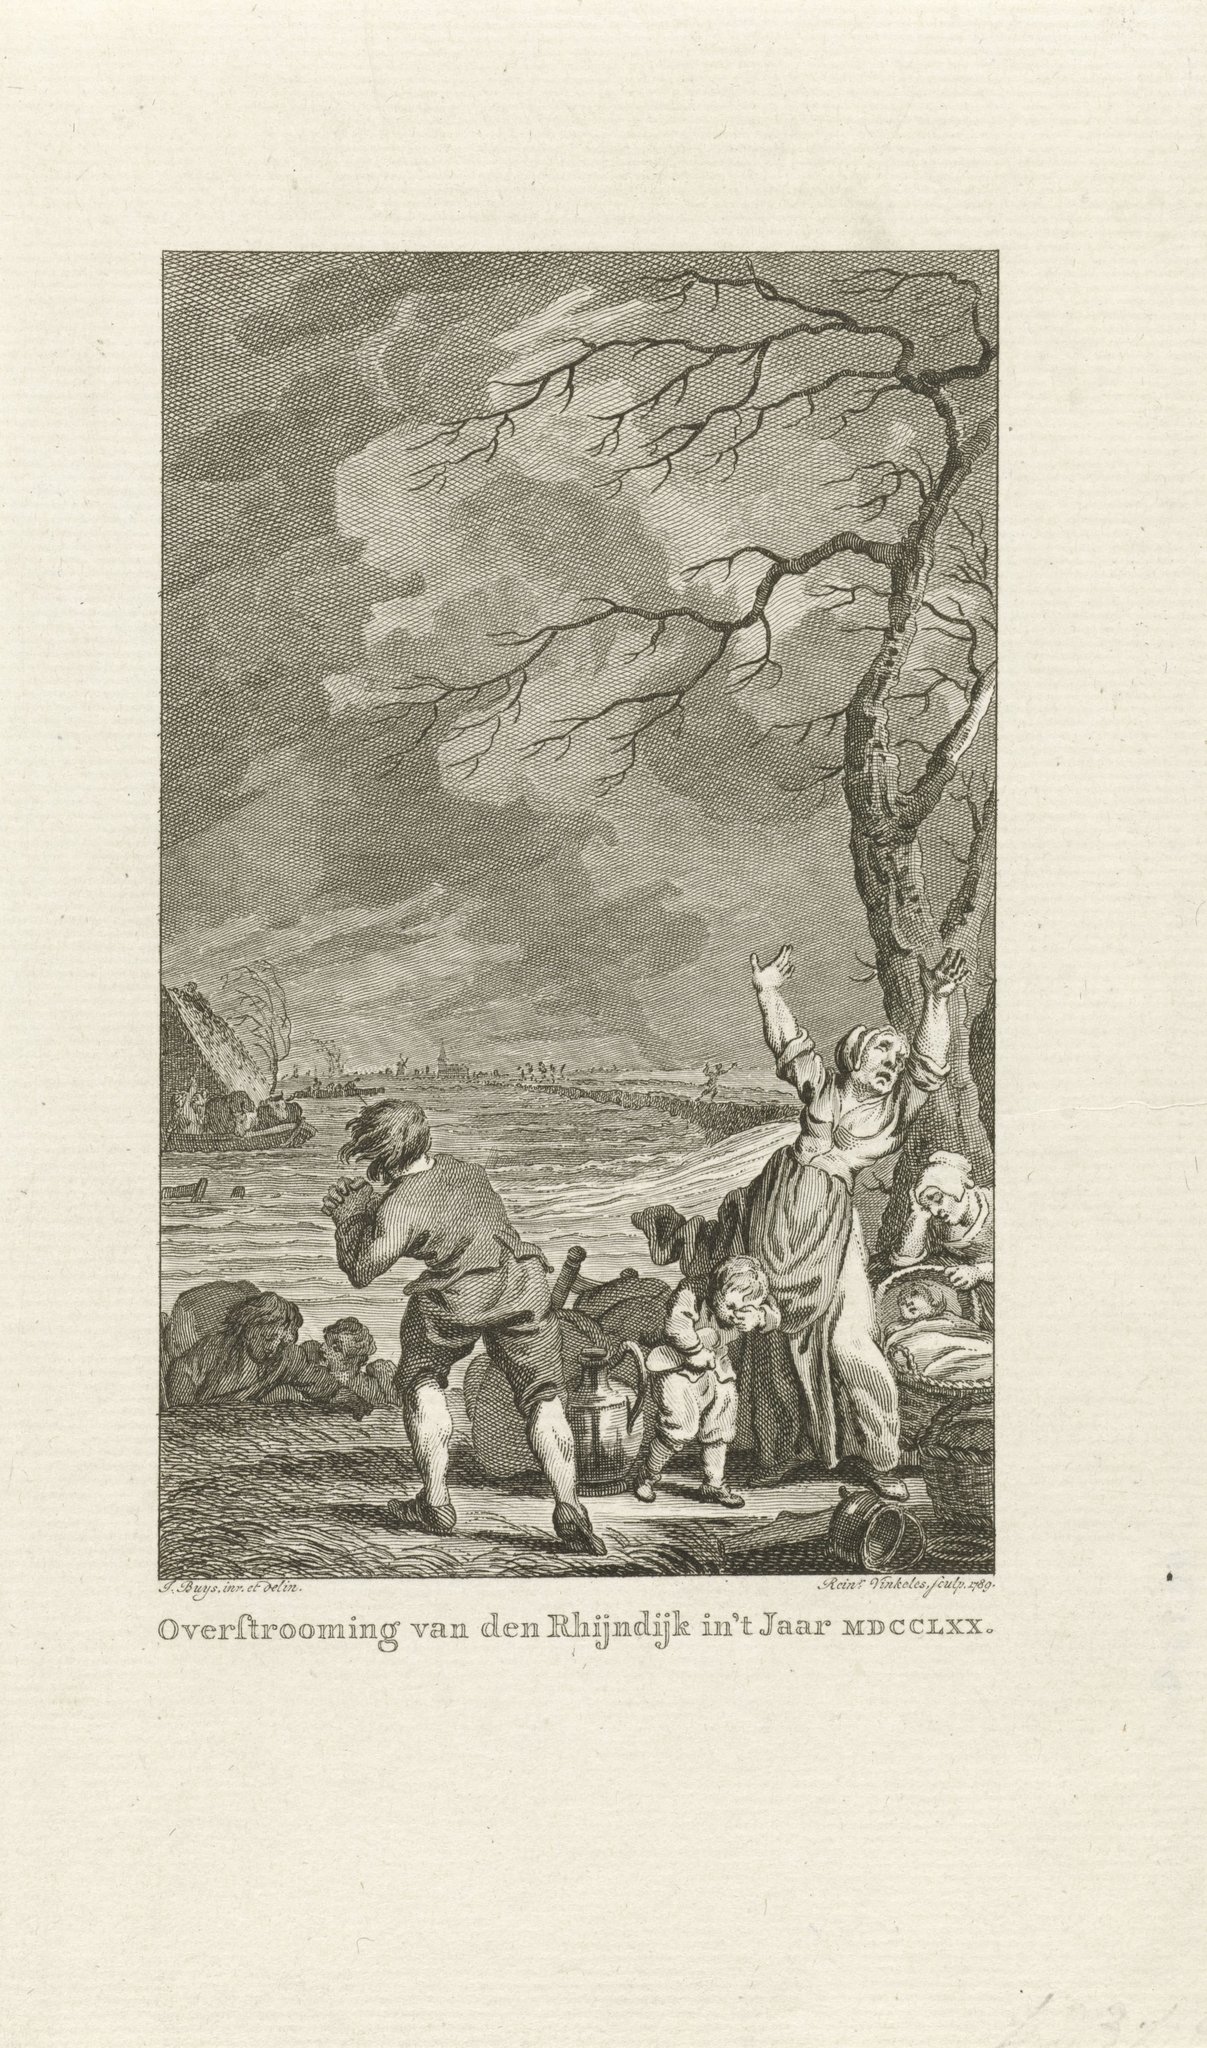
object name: print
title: Overstroming van de Rijndijk in Gelderland, 1770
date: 1789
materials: paper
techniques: etching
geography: northern netherlands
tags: dike-break, gelderland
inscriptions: collector's mark: Lugt 2228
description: Gebruikt als illustratie in: P.A. Loosjes, Vaderlandsche historie, vervattende de geschiedenissen, der Vereenigde Nederlanden (...). Vier-en-twintigste deel. Beginnende met den jaare 1766 en eindigende met den jaare 1774, bevattende het tydperk der meerderjaarigheid des erfstadhouders Willem den V, tot de Americaensche onlusten. Ten onmiddelyken vervolge van Wagenaar's Vaderlandsche historie. Amsterdam: Johannes Allart, 1789.